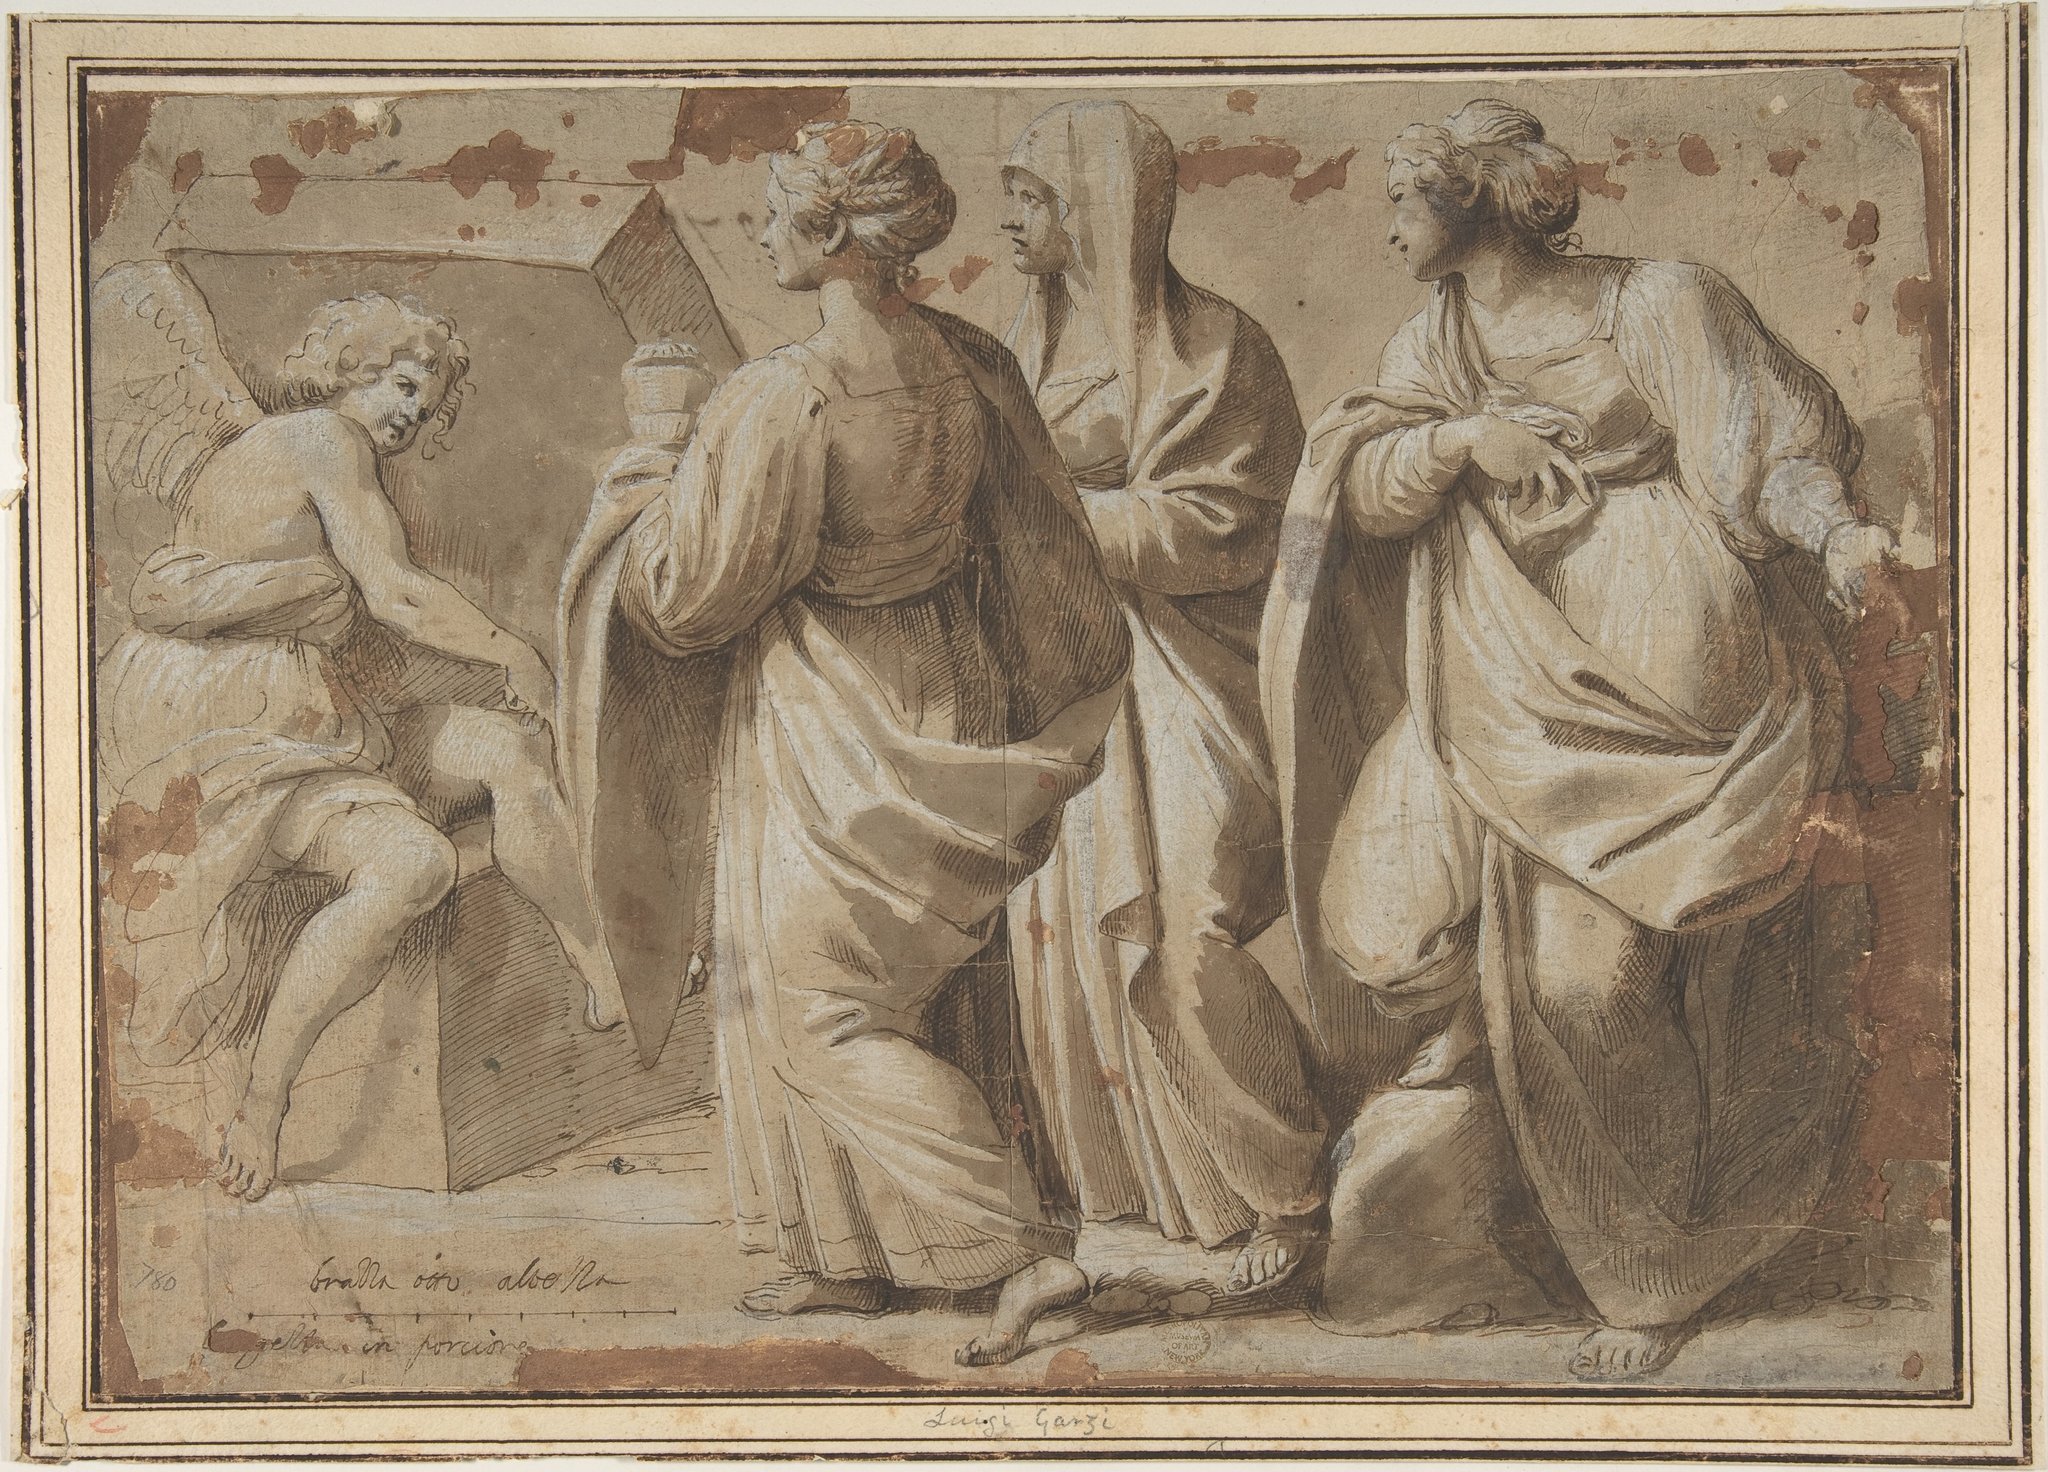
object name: drawing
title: The Holy Women at the Sepulchre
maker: sisto badalocchio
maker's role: artist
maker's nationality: italian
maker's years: 1585-1619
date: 1585-1620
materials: ink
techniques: brush, highlighting, pen, wash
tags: women,angels